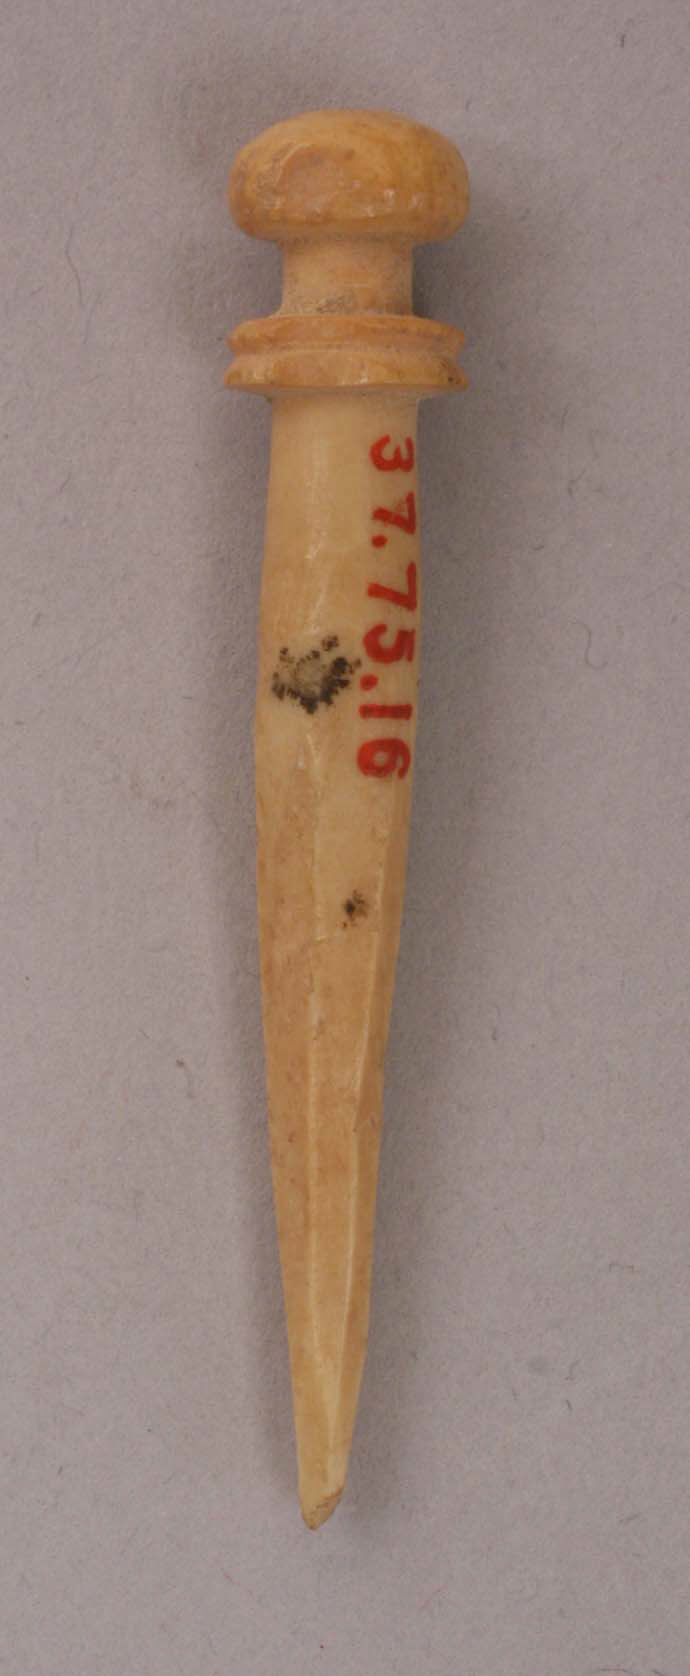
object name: pin or stylus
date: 401-800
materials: bone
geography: palestine